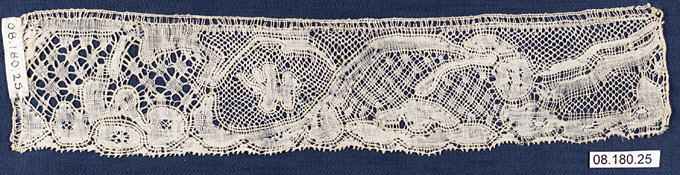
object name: fragment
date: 1601-1700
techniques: lace